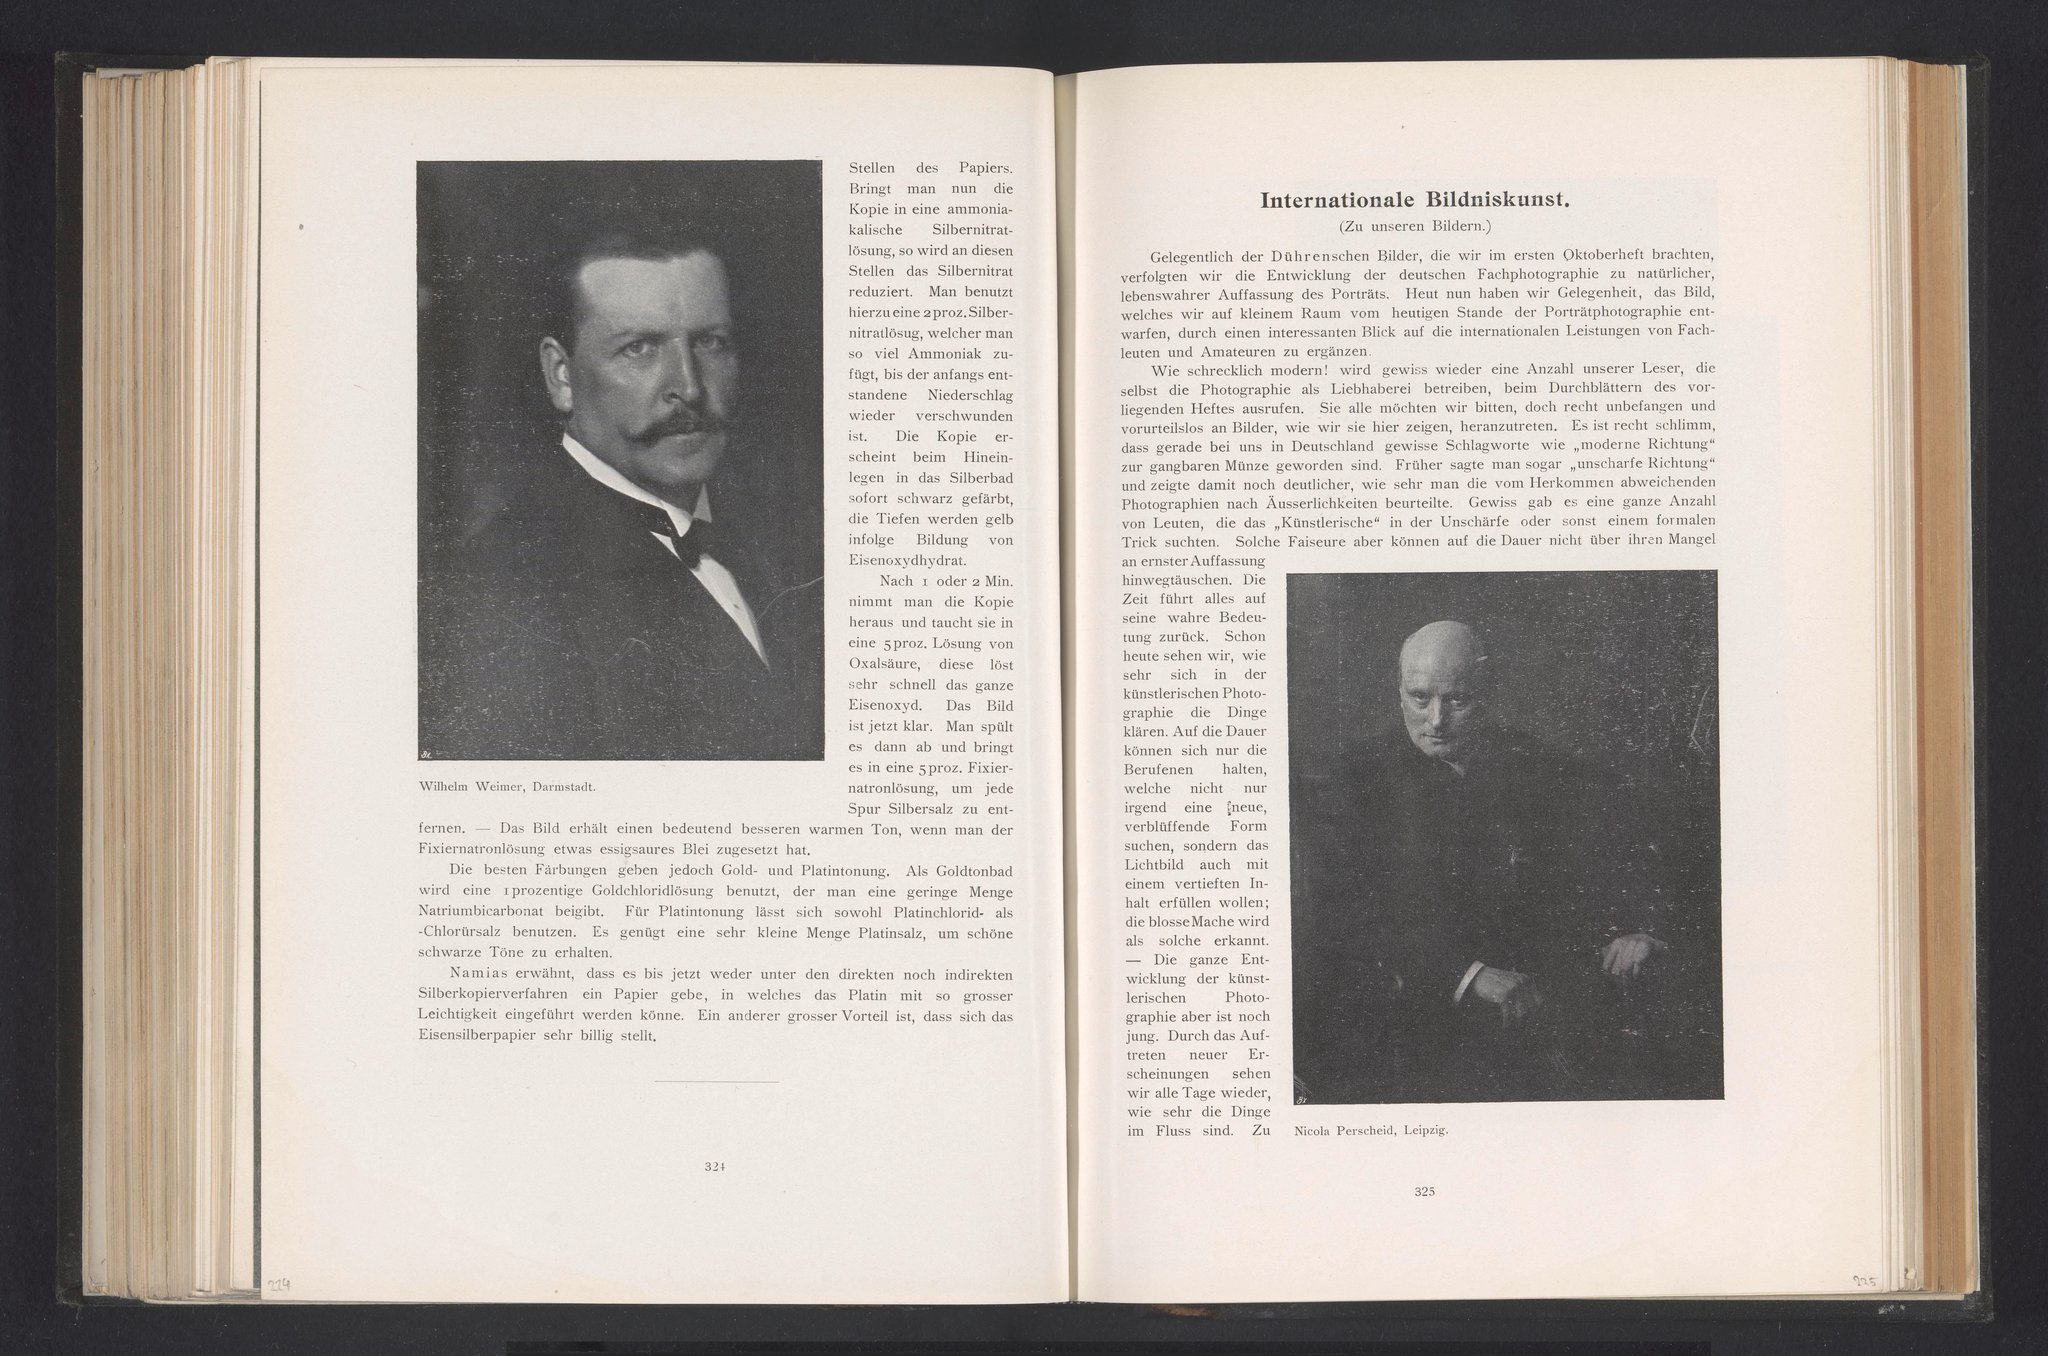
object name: photomechanical print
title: Portret van een onbekende man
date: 1898-1903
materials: paper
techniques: autotype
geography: darmstadt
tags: historical persons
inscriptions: monogram: ‘BX’